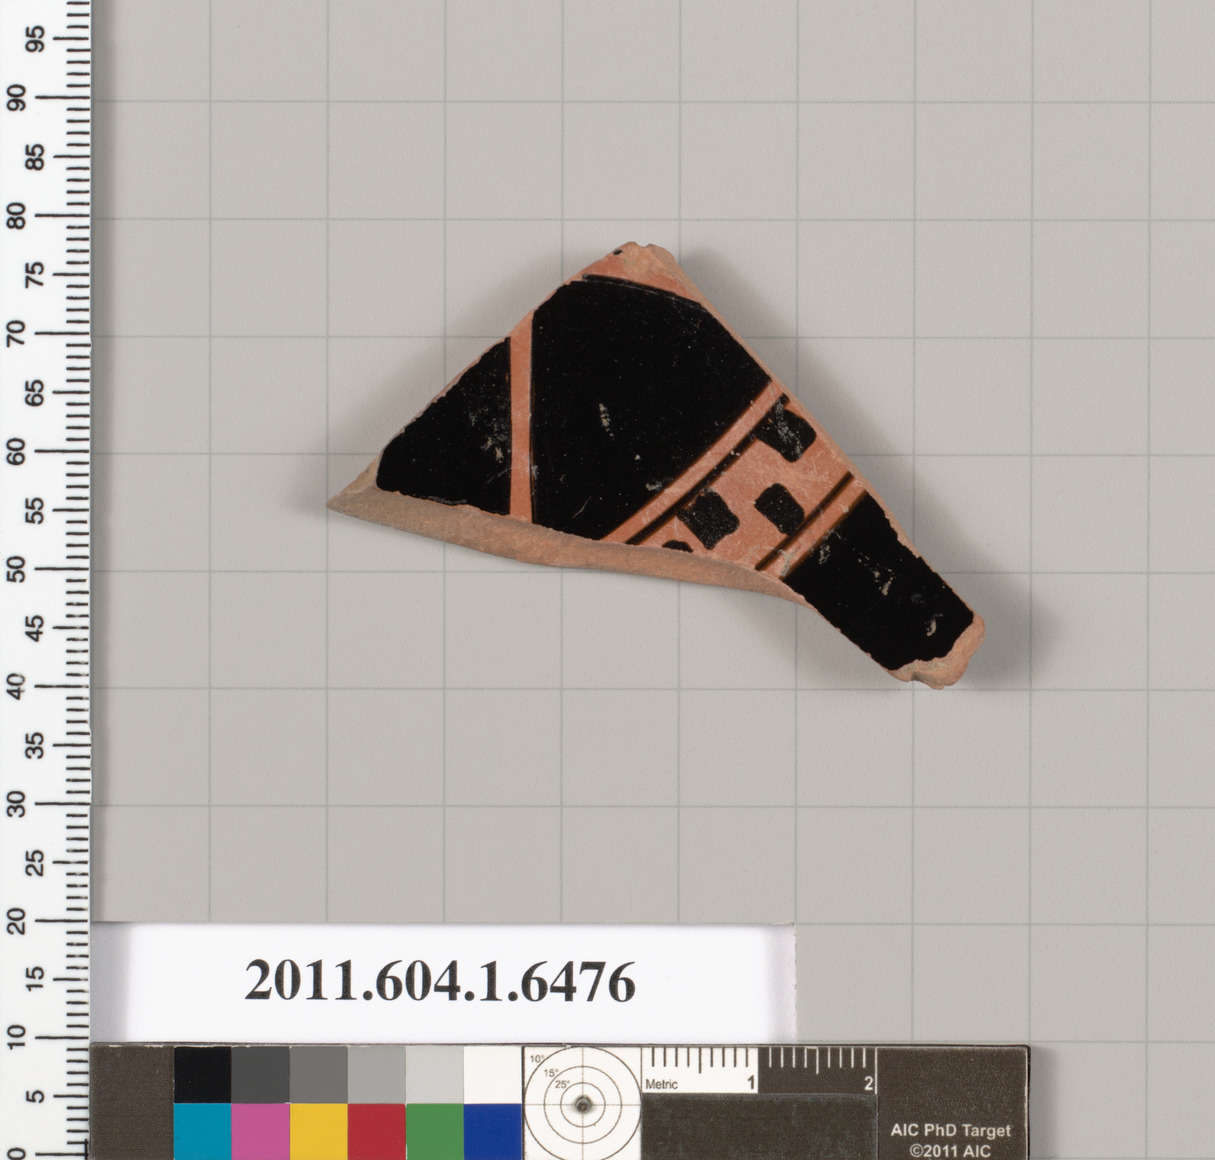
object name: kylix fragment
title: Terracotta fragment of a kylix (drinking cup)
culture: greek, attic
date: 490-480 BCE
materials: terracotta